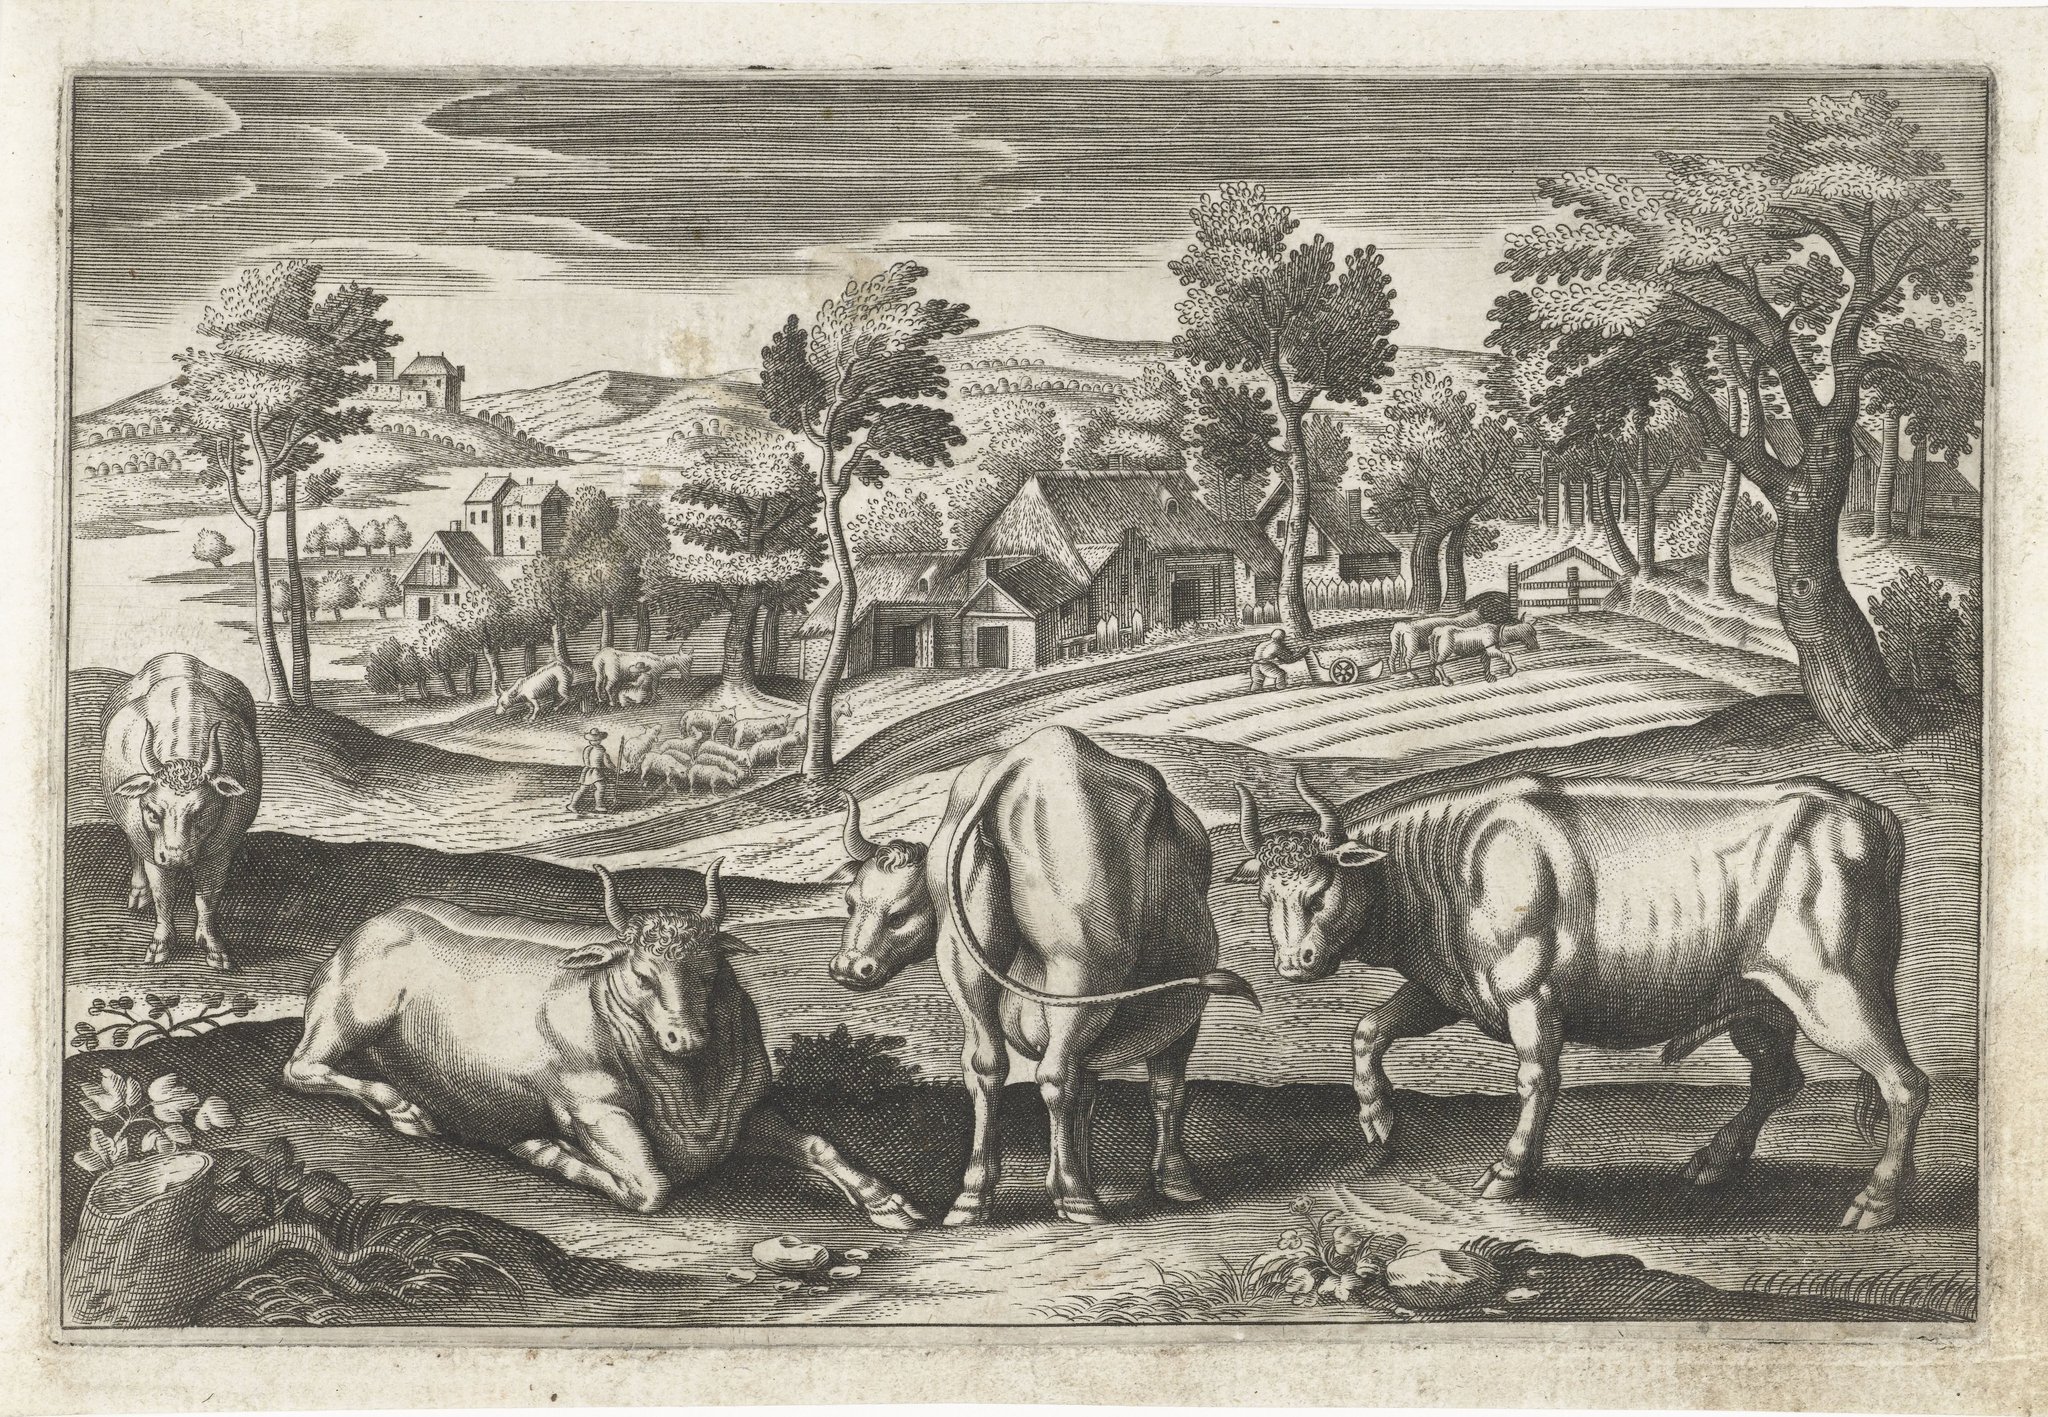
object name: print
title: Vierpotige dieren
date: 1595-1652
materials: paper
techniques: engraving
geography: amsterdam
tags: bull, farm or solitary house in landscape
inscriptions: collector's mark: Lugt 2228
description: Op de voorgrond vier stieren. Op de achtergrond een landschap met een boerderij. De prent maakt deel uit van een serie met dieren als onderwerp.